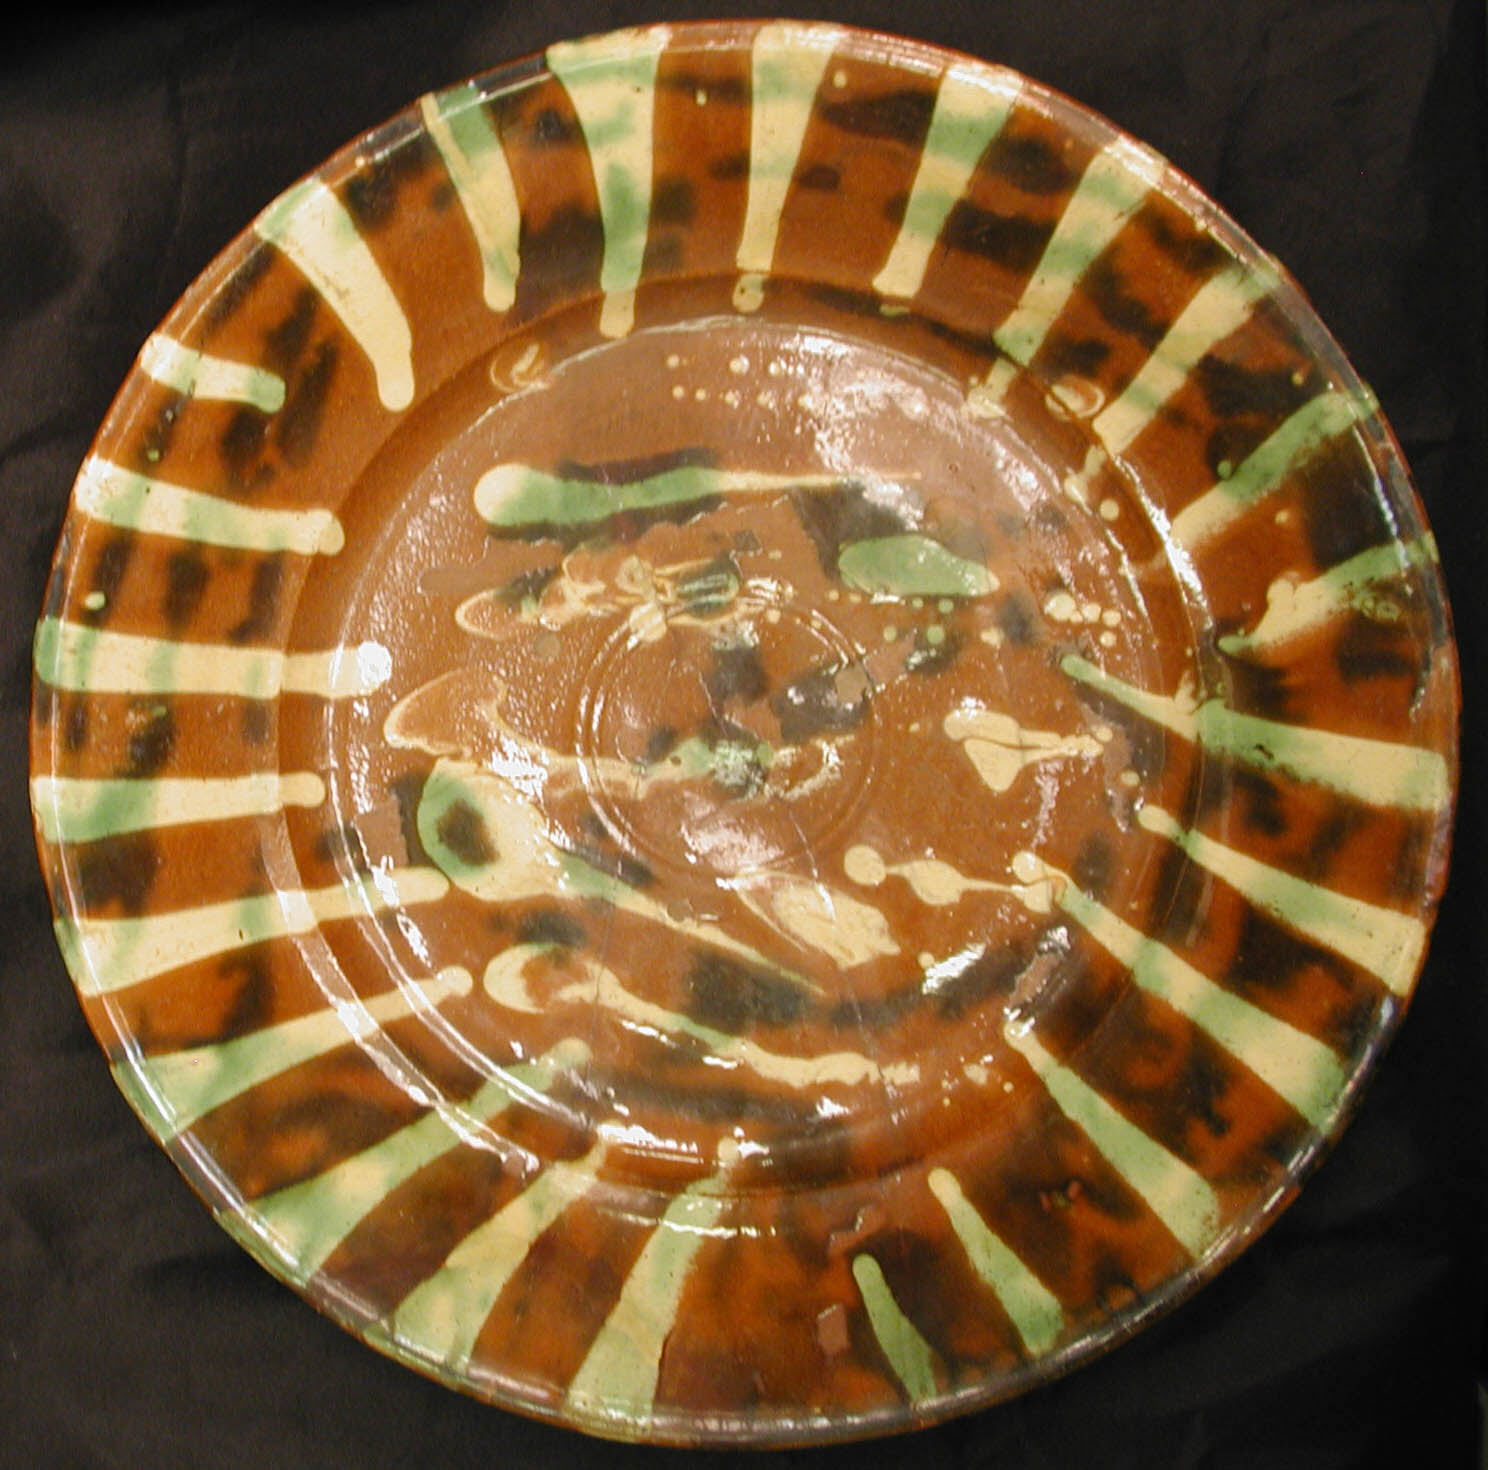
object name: dish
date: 1601-1700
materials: pottery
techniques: glazing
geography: iran